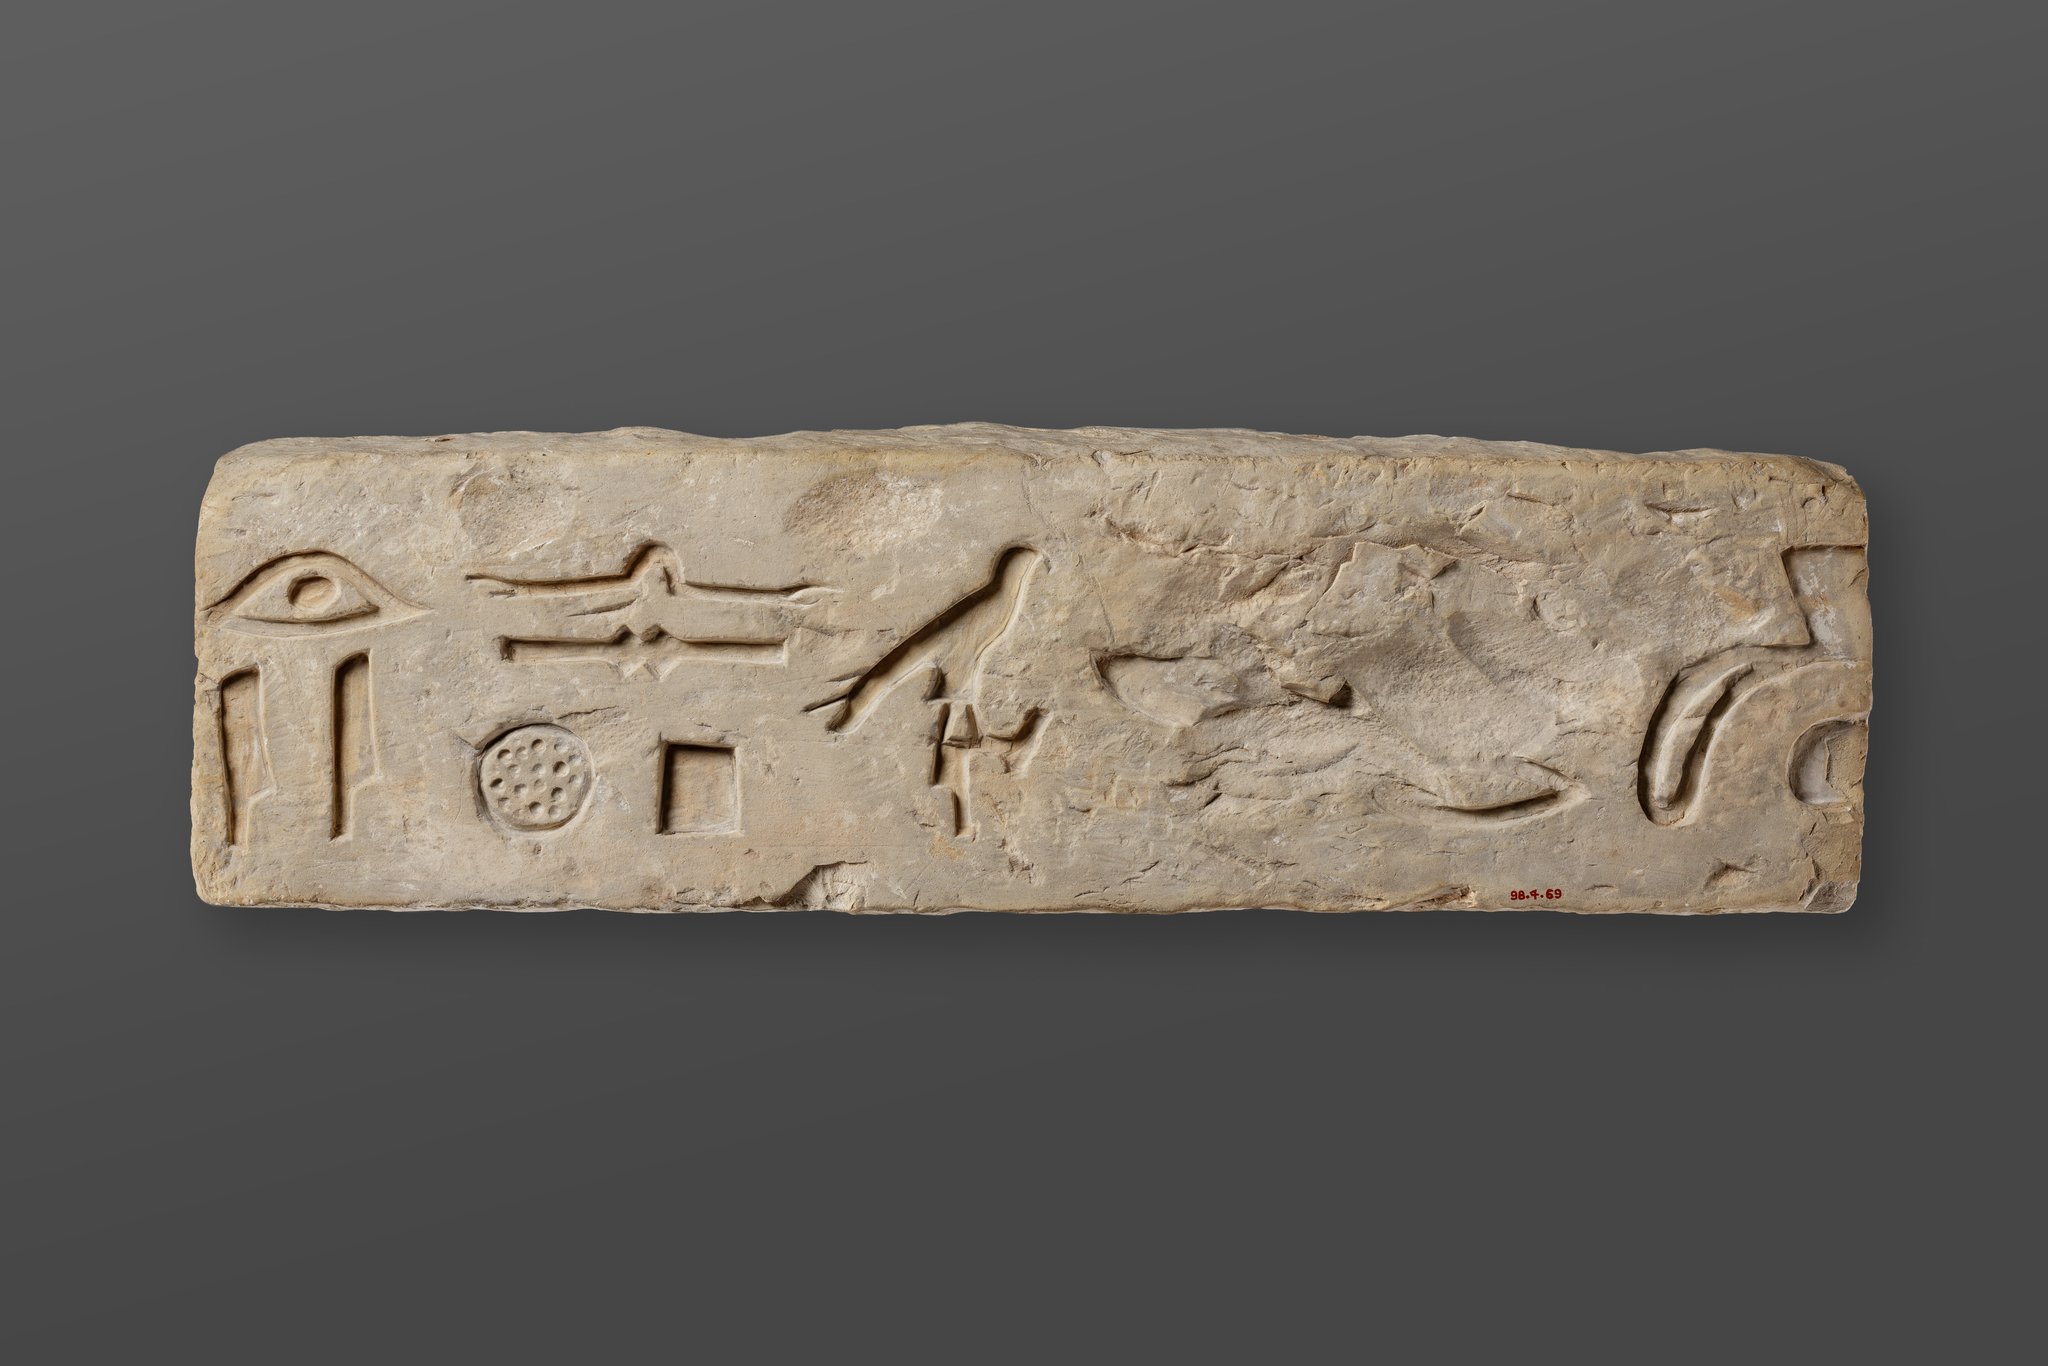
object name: relief fragment, tomb of mereri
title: Relief fragment, tomb of Mereri (?)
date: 2100-2090 BCE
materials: limestone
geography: egypt